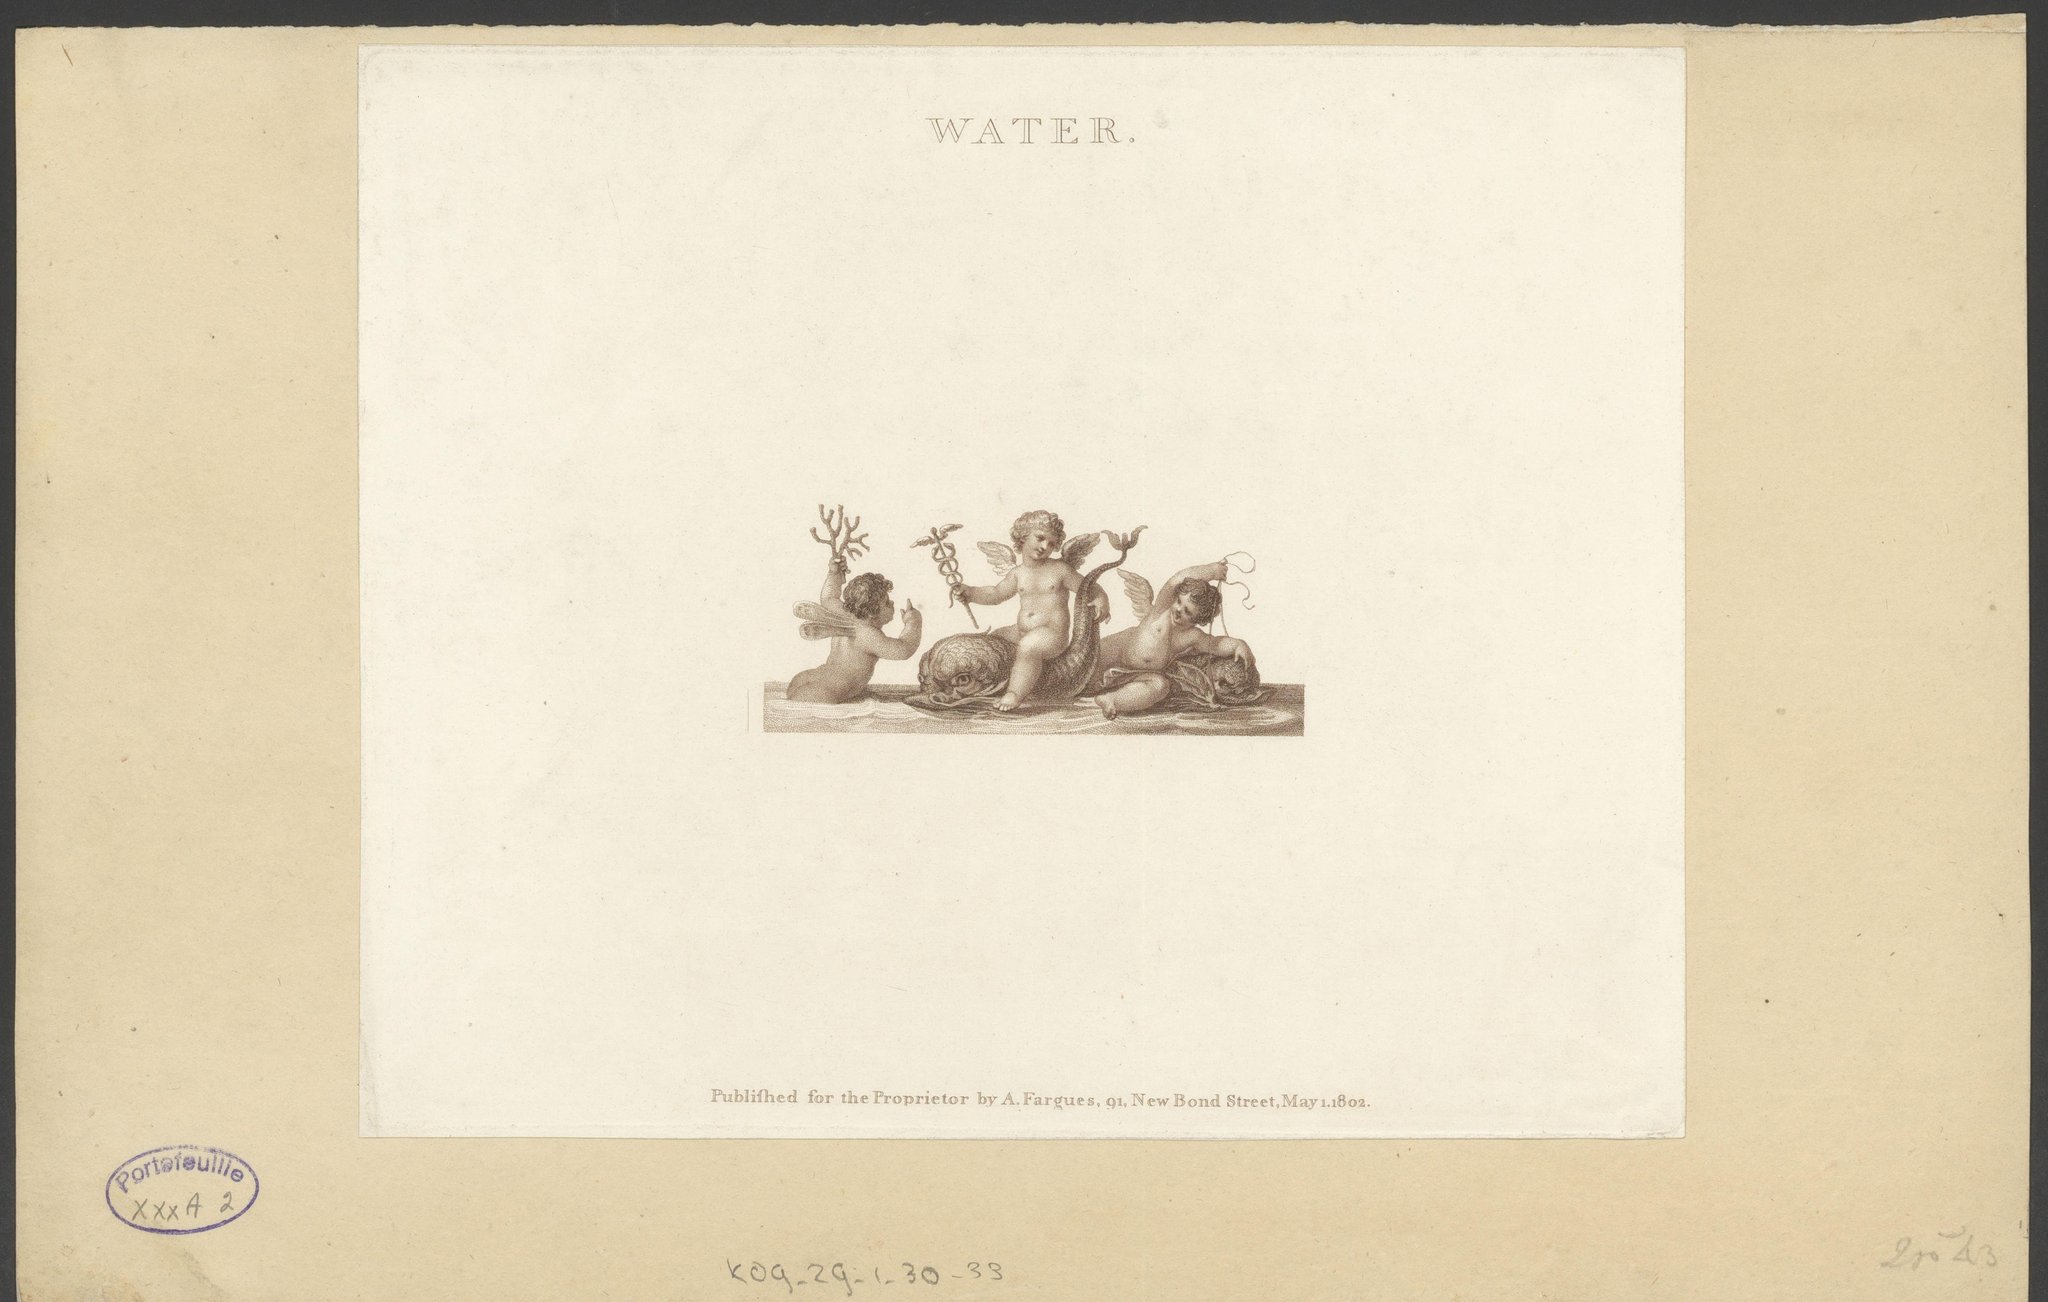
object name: print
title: Vier elementen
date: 1802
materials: paper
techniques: etching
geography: amsterdam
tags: swimming mammals: dolphin, water (one of the four elements), cupids: 'amores', 'amoretti', 'putti'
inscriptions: stamp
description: Drie putti beelden het element Water uit. Links een putto met een stuk koraal in zijn hand. In het midden een putto op een dolfijn en met een caduceus in zijn hand en rechts nog een putto met een dolfijn. Onderwerpsrubrieken binnen de Atlas Zeden en Gewoonten: Zeden en Gewoonten in engeren zin. Volksleven. Zinnebeeldige voorstellingen uit het volkleven op serieprenten. Elementen.